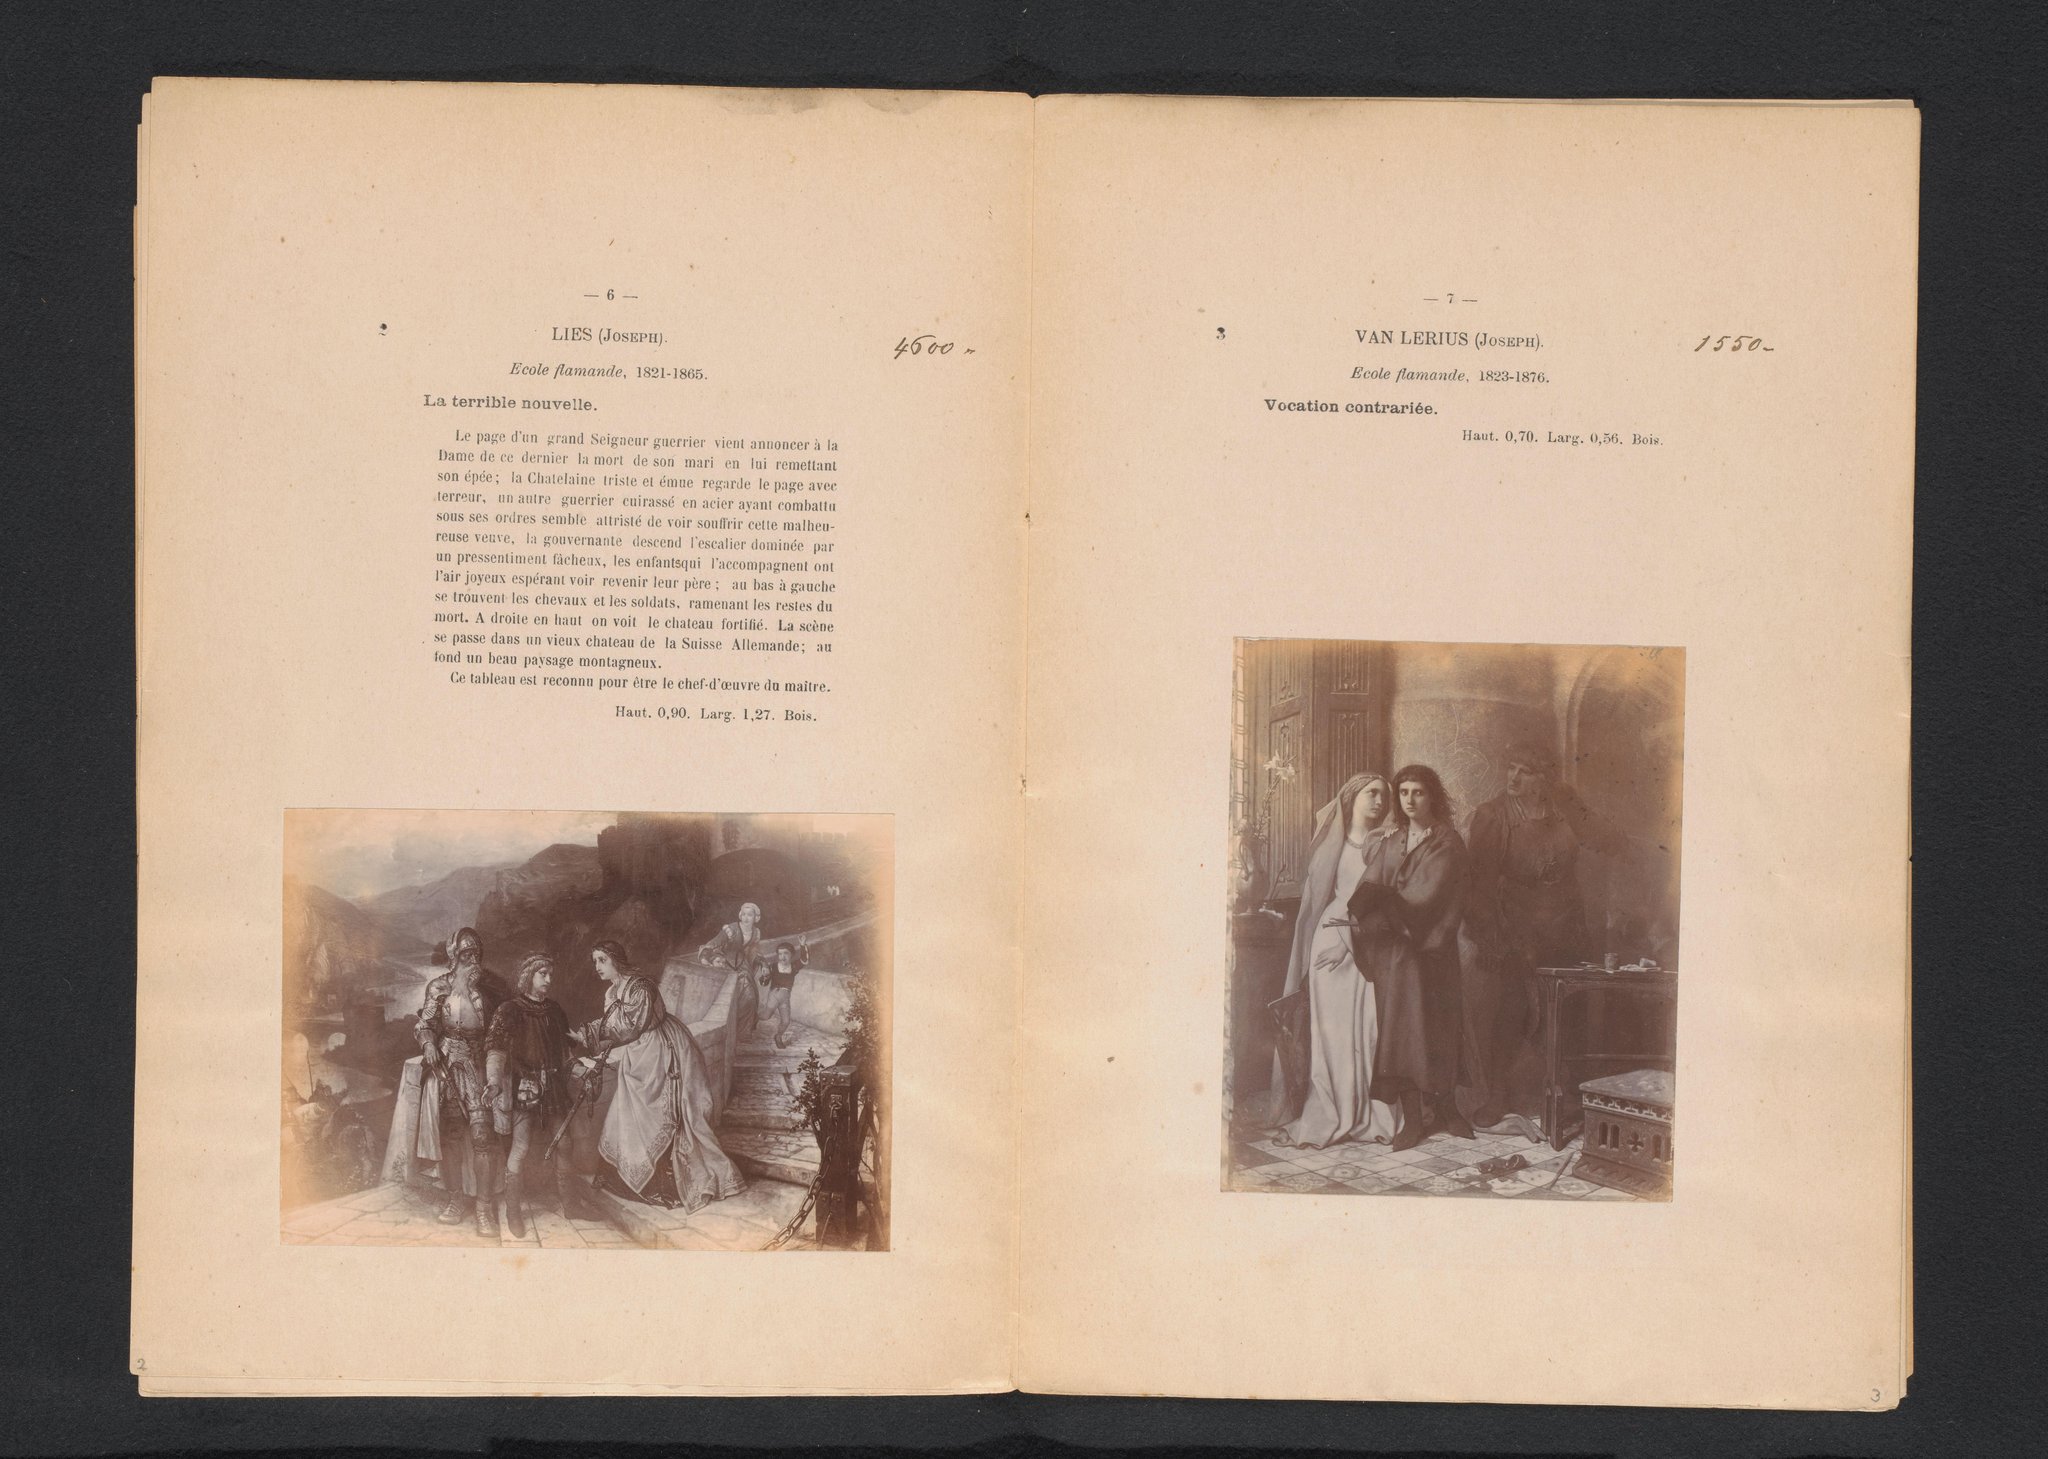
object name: photograph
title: Fotoreproductie van een schilderij van een liefdespaar en een man door Jozef van Lerius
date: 1886-1891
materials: photographic support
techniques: gelatin silver print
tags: adult man, couple of lovers